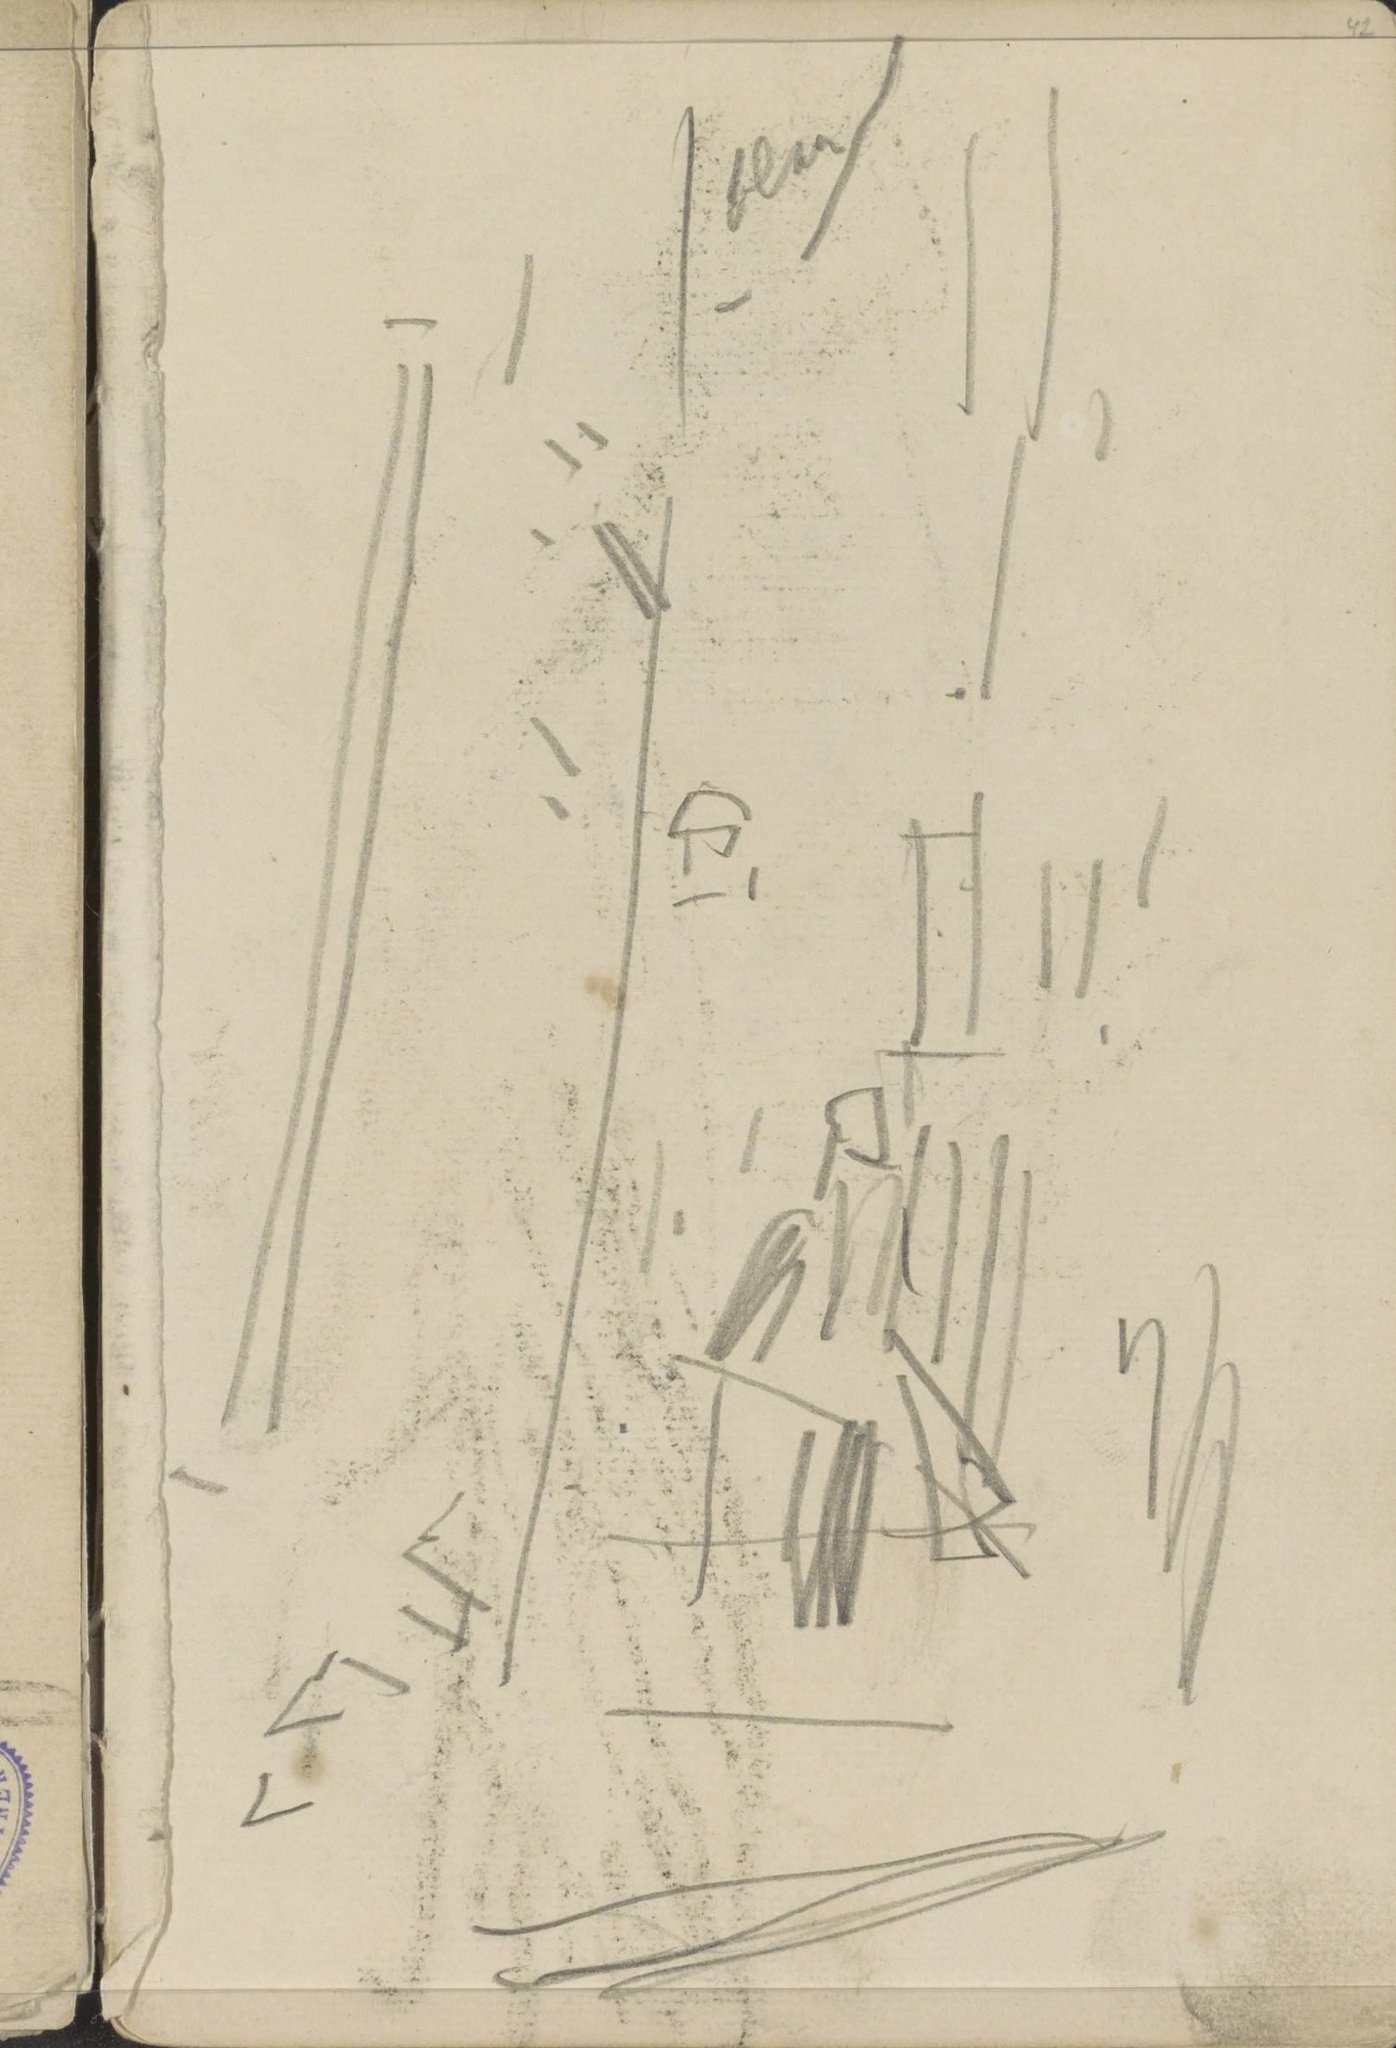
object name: sketchbook leaf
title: Figuur, mogelijk op straat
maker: george hendrik breitner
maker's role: draughtsman, painter, print maker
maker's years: 1857-1923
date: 1886-1923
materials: paper, pencil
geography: amsterdam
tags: trees, street (+ city(-scape) with figures, staffage), amsterdam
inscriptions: kleurnotitie, handgeschreven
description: Pagina 42 uit een schetsboek met 19 bladen en 9 losse tekeningen.